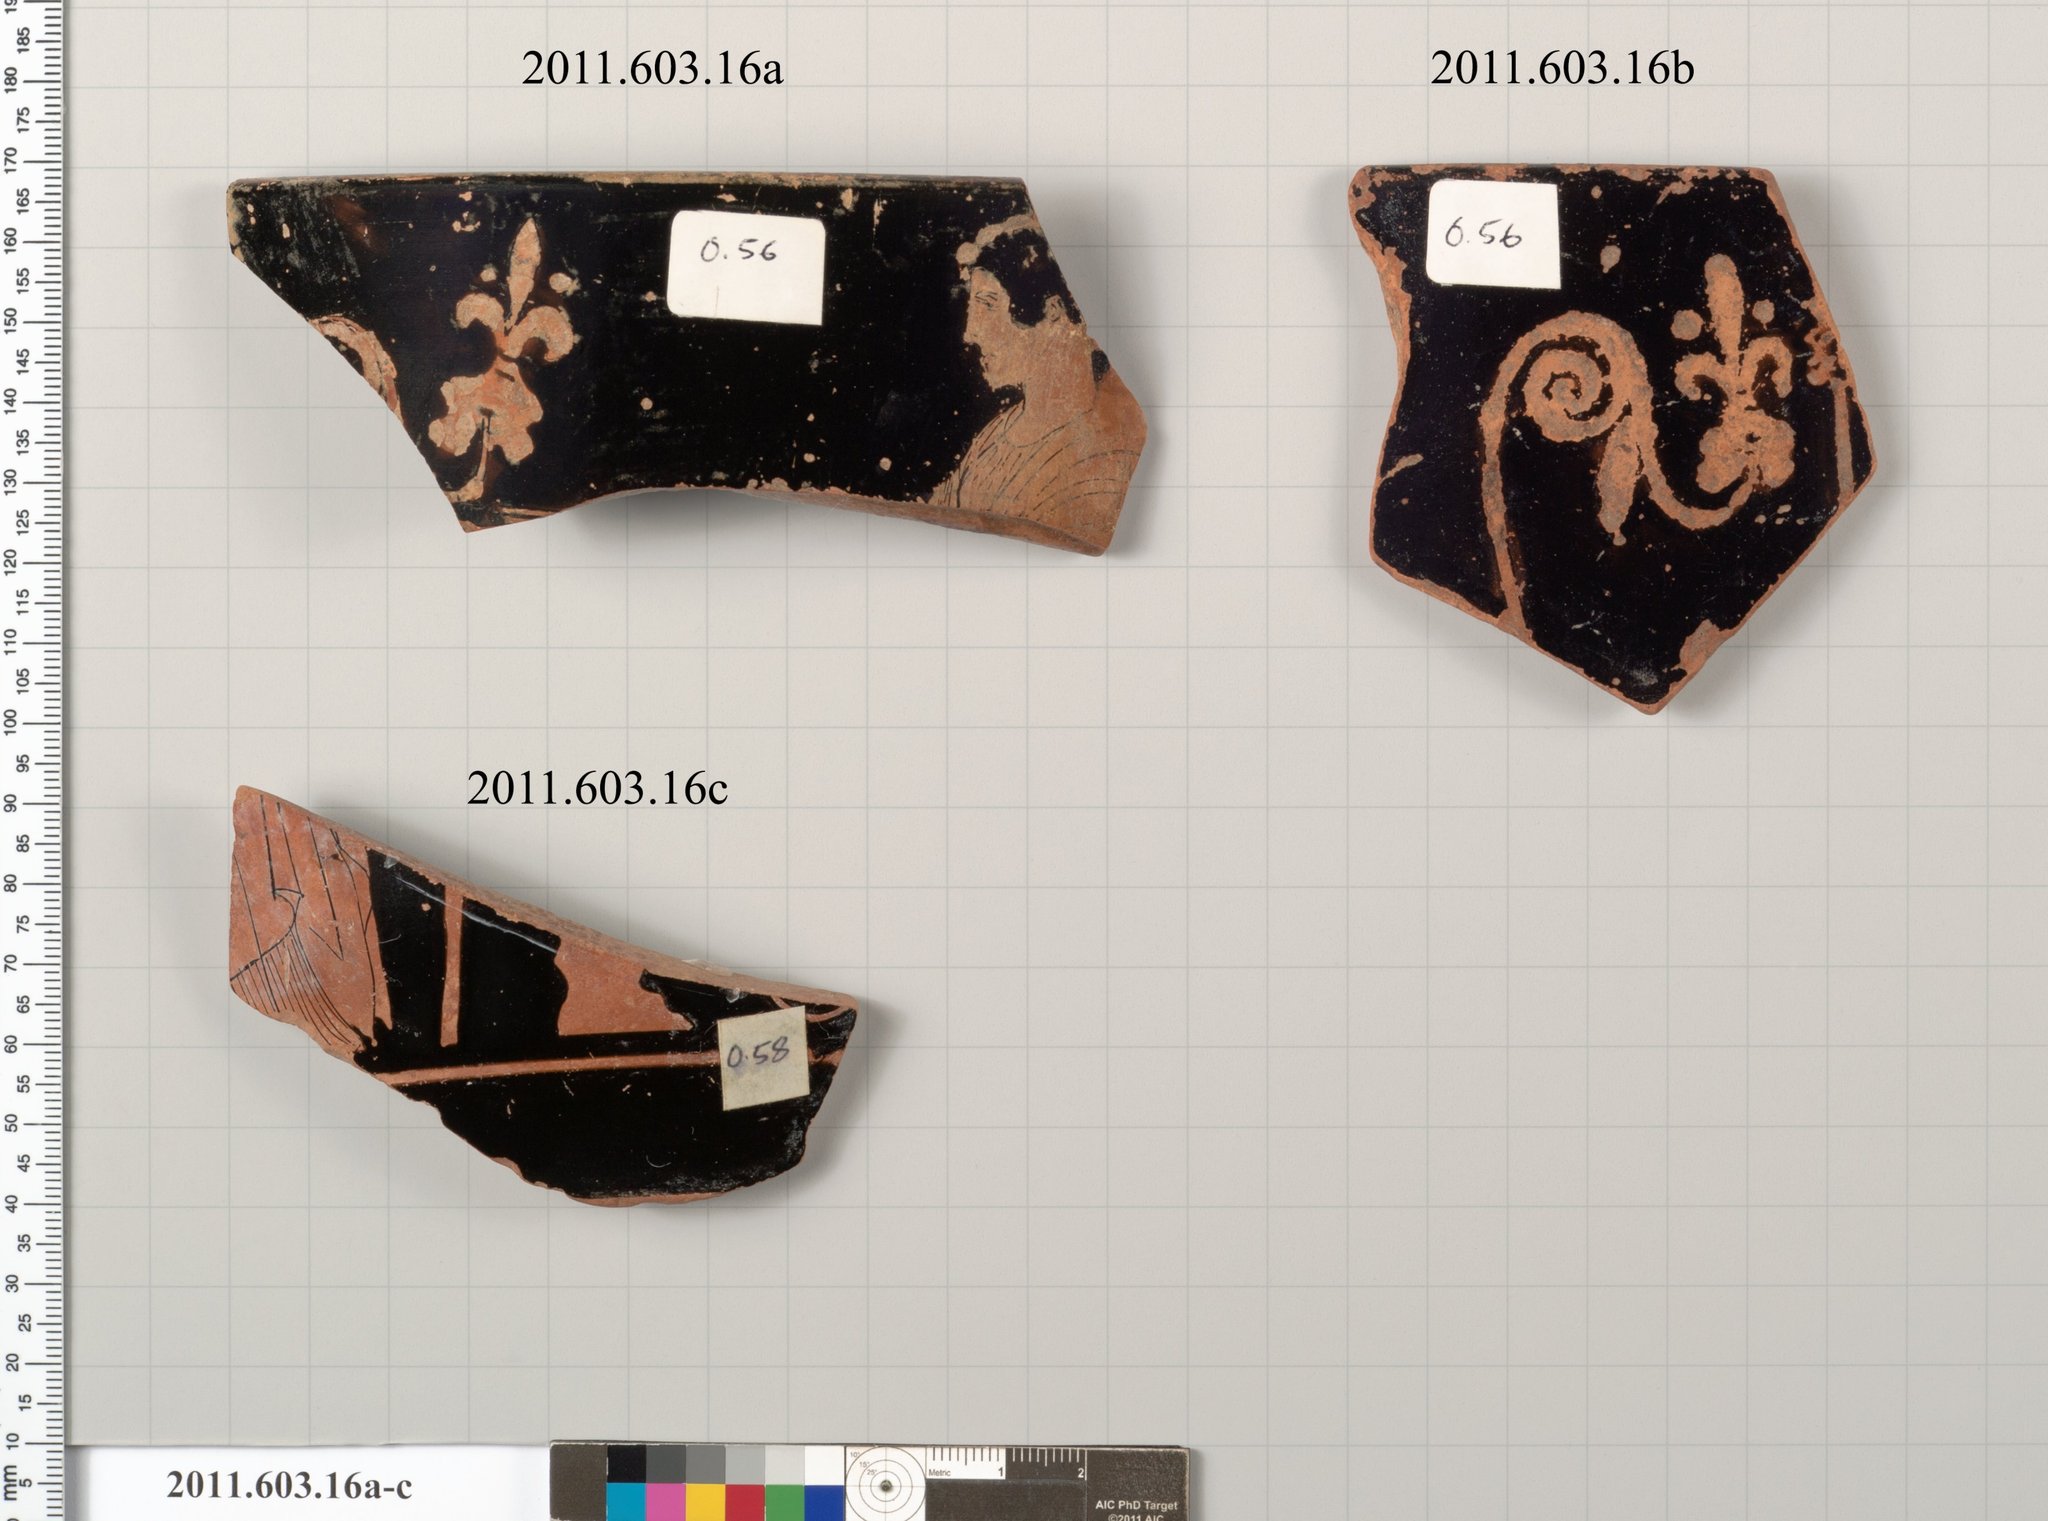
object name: skyphos fragment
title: Fragments of a terracotta skyphos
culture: greek, attic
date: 467-435 BCE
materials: terracotta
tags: profiles,women